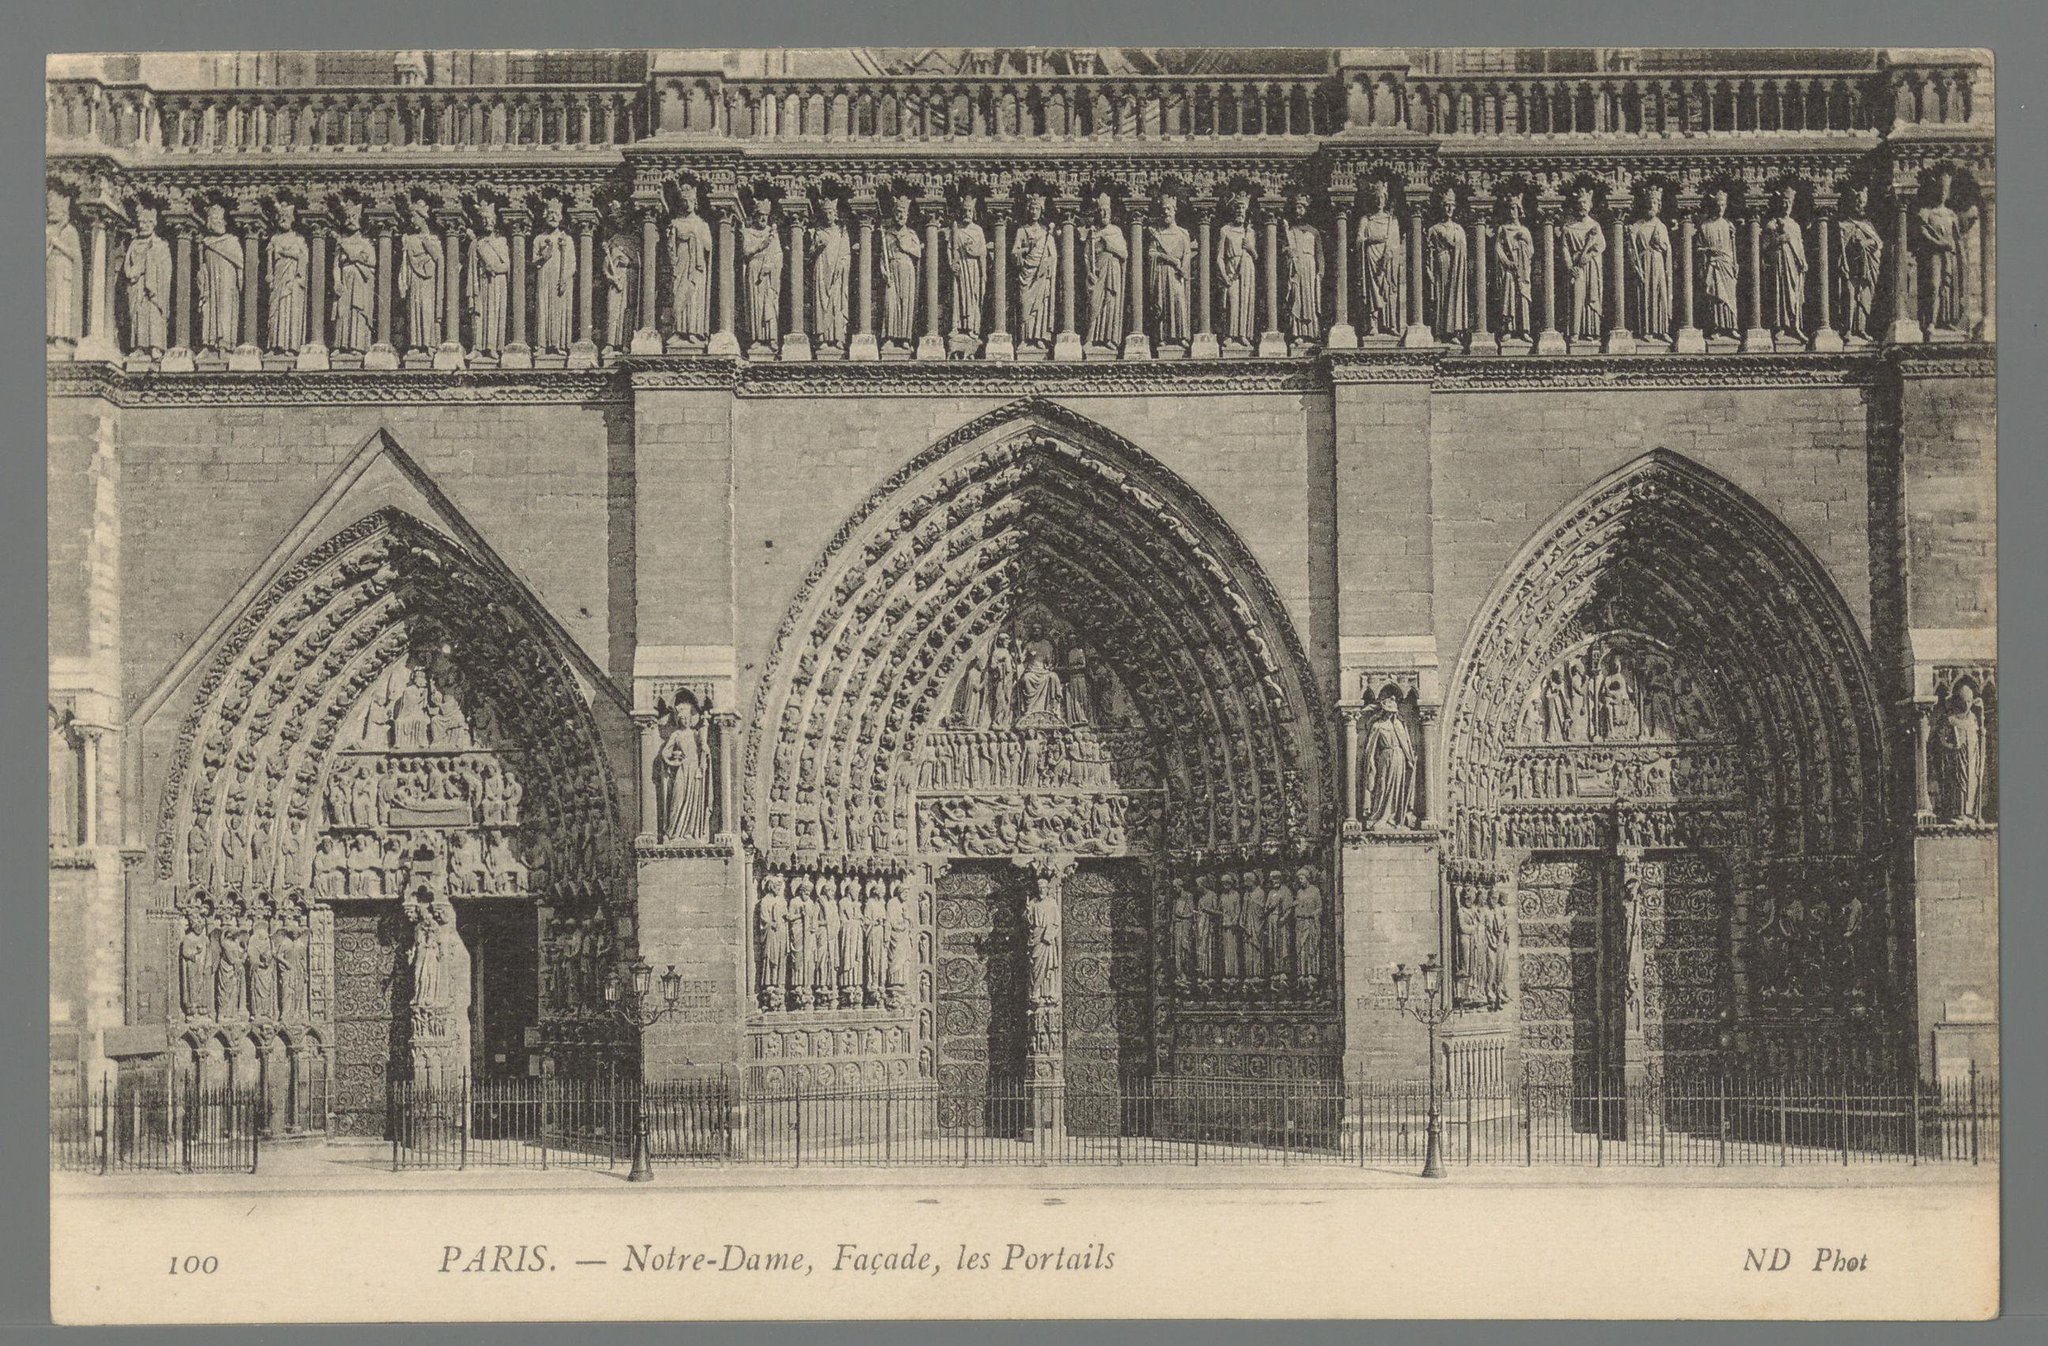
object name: photomechanical print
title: Paris. Notre-Dame, Façade, les Portails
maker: Anonymous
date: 1904-1906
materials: cardboard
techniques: photograph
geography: paris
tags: parts of church exterior and annexes: portal